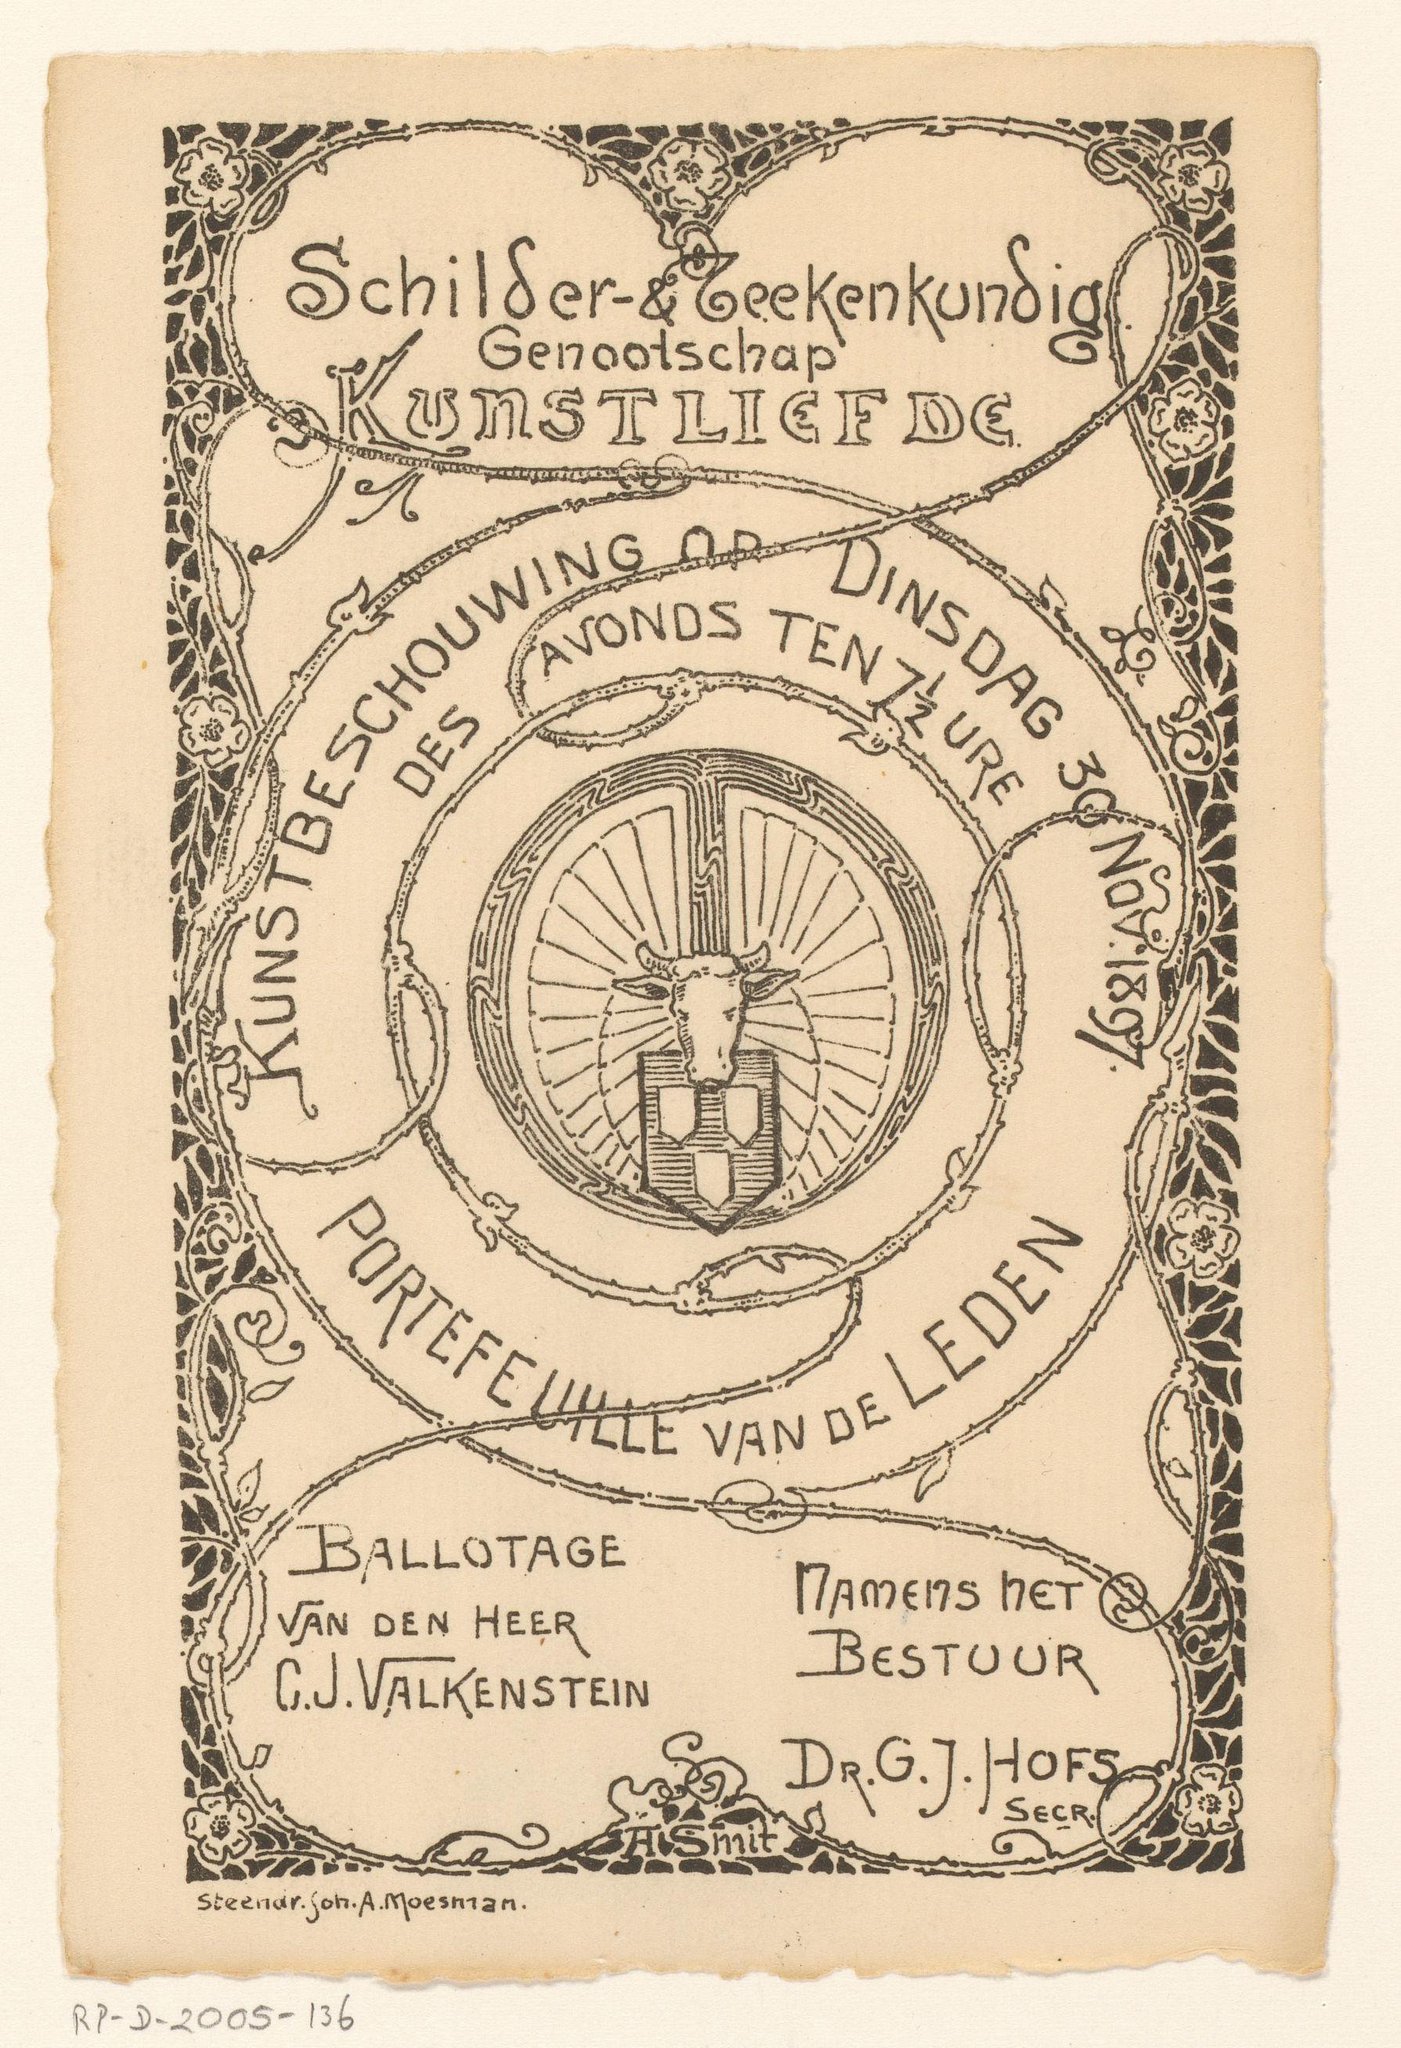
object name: invitation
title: Uitnodiging van Schilder- en Teekenkundig Genootschap "Kunstliefde" voor een kunstbeschouwing, 30 november 1897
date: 1811-1897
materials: paper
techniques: lithograph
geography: netherlands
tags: criticizing and discussing art, art criticism, circle, club of artists, collecting and exhibiting products of the fine arts, foliage, tendrils, branches ~ ornament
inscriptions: collector's mark: Lugt 2228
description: Ornament met slingerende ranken. Uitnodiging van Schilder- en Teekenkundig Genootschap "Kunstliefde" voor een kunstbeschouwing op 30 november 1897 van de portefeuille van de leden.